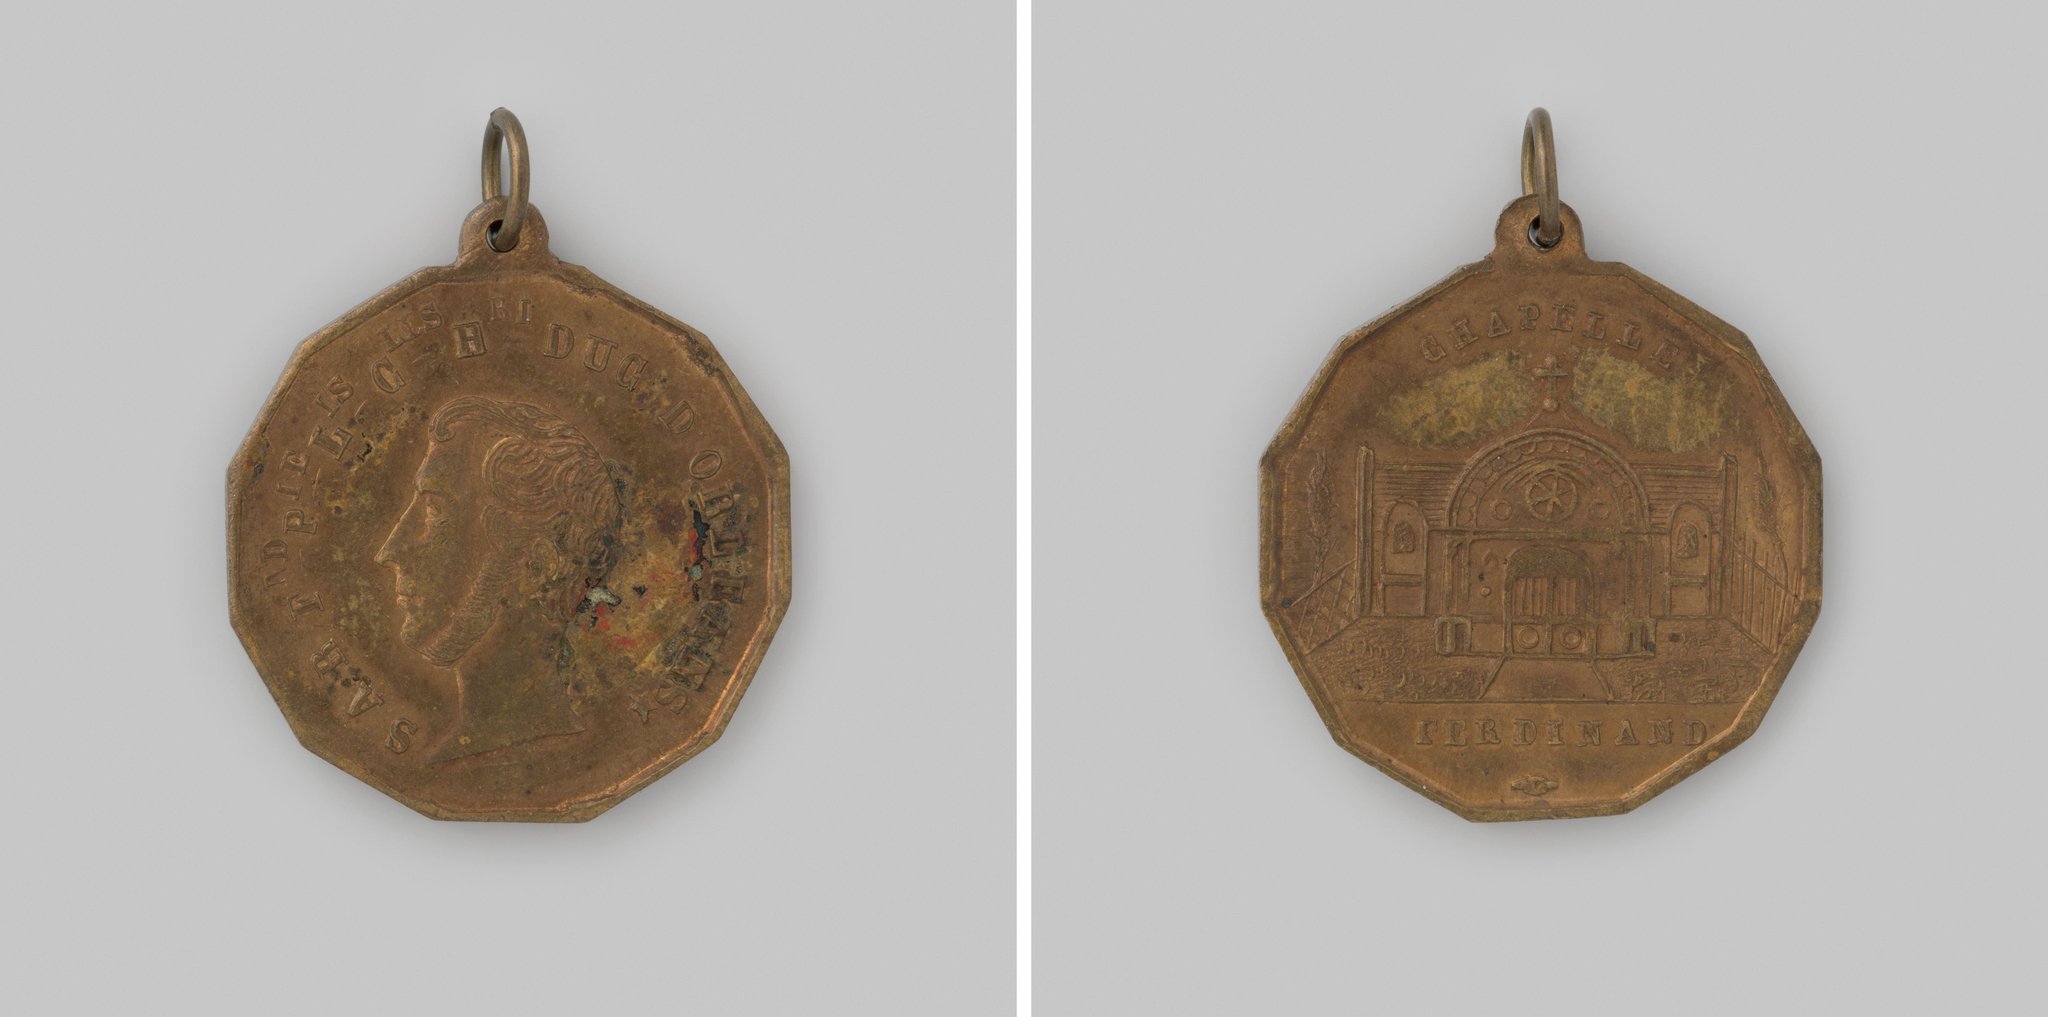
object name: history medal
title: Oprichting van de Kapel St Ferdinand ter ere van de hertog van Orléans 1843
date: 1843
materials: brass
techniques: striking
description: Twaalfhoekige messing penning met oog en draagring, op de voorzijde het portret van de hertog van Orléans naar links met omschrift, op de keerzijde het aanzicht van een kapel met omschrift en afsnedetekst.